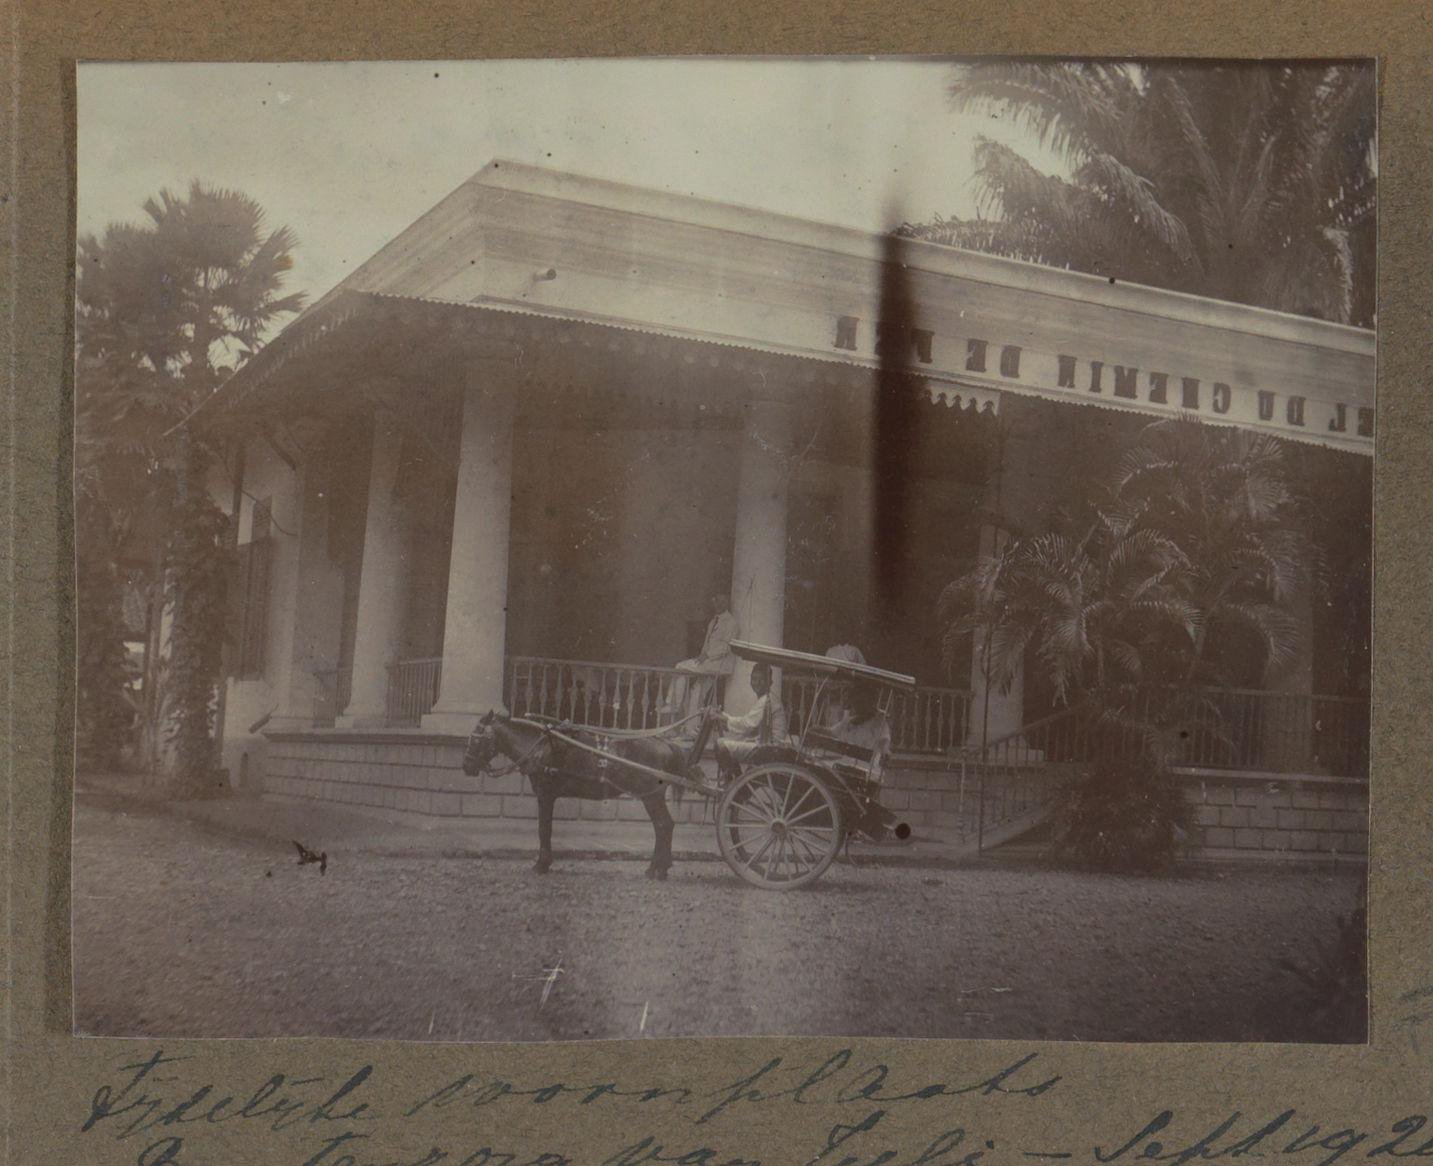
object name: photograph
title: Paard en wagen voor Hotel du Chemin de Fer in Buitenzorg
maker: Anonymous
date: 1909-1920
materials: photographic support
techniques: gelatin silver print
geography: buitenzorg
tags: two-wheeled, animal-drawn vehicle, station; shelter (railway, tramway)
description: Onderdeel van fotoalbum van een onbekende Nederlandse familie met opnames van Suriname, Europa en Nederlands-Indië.